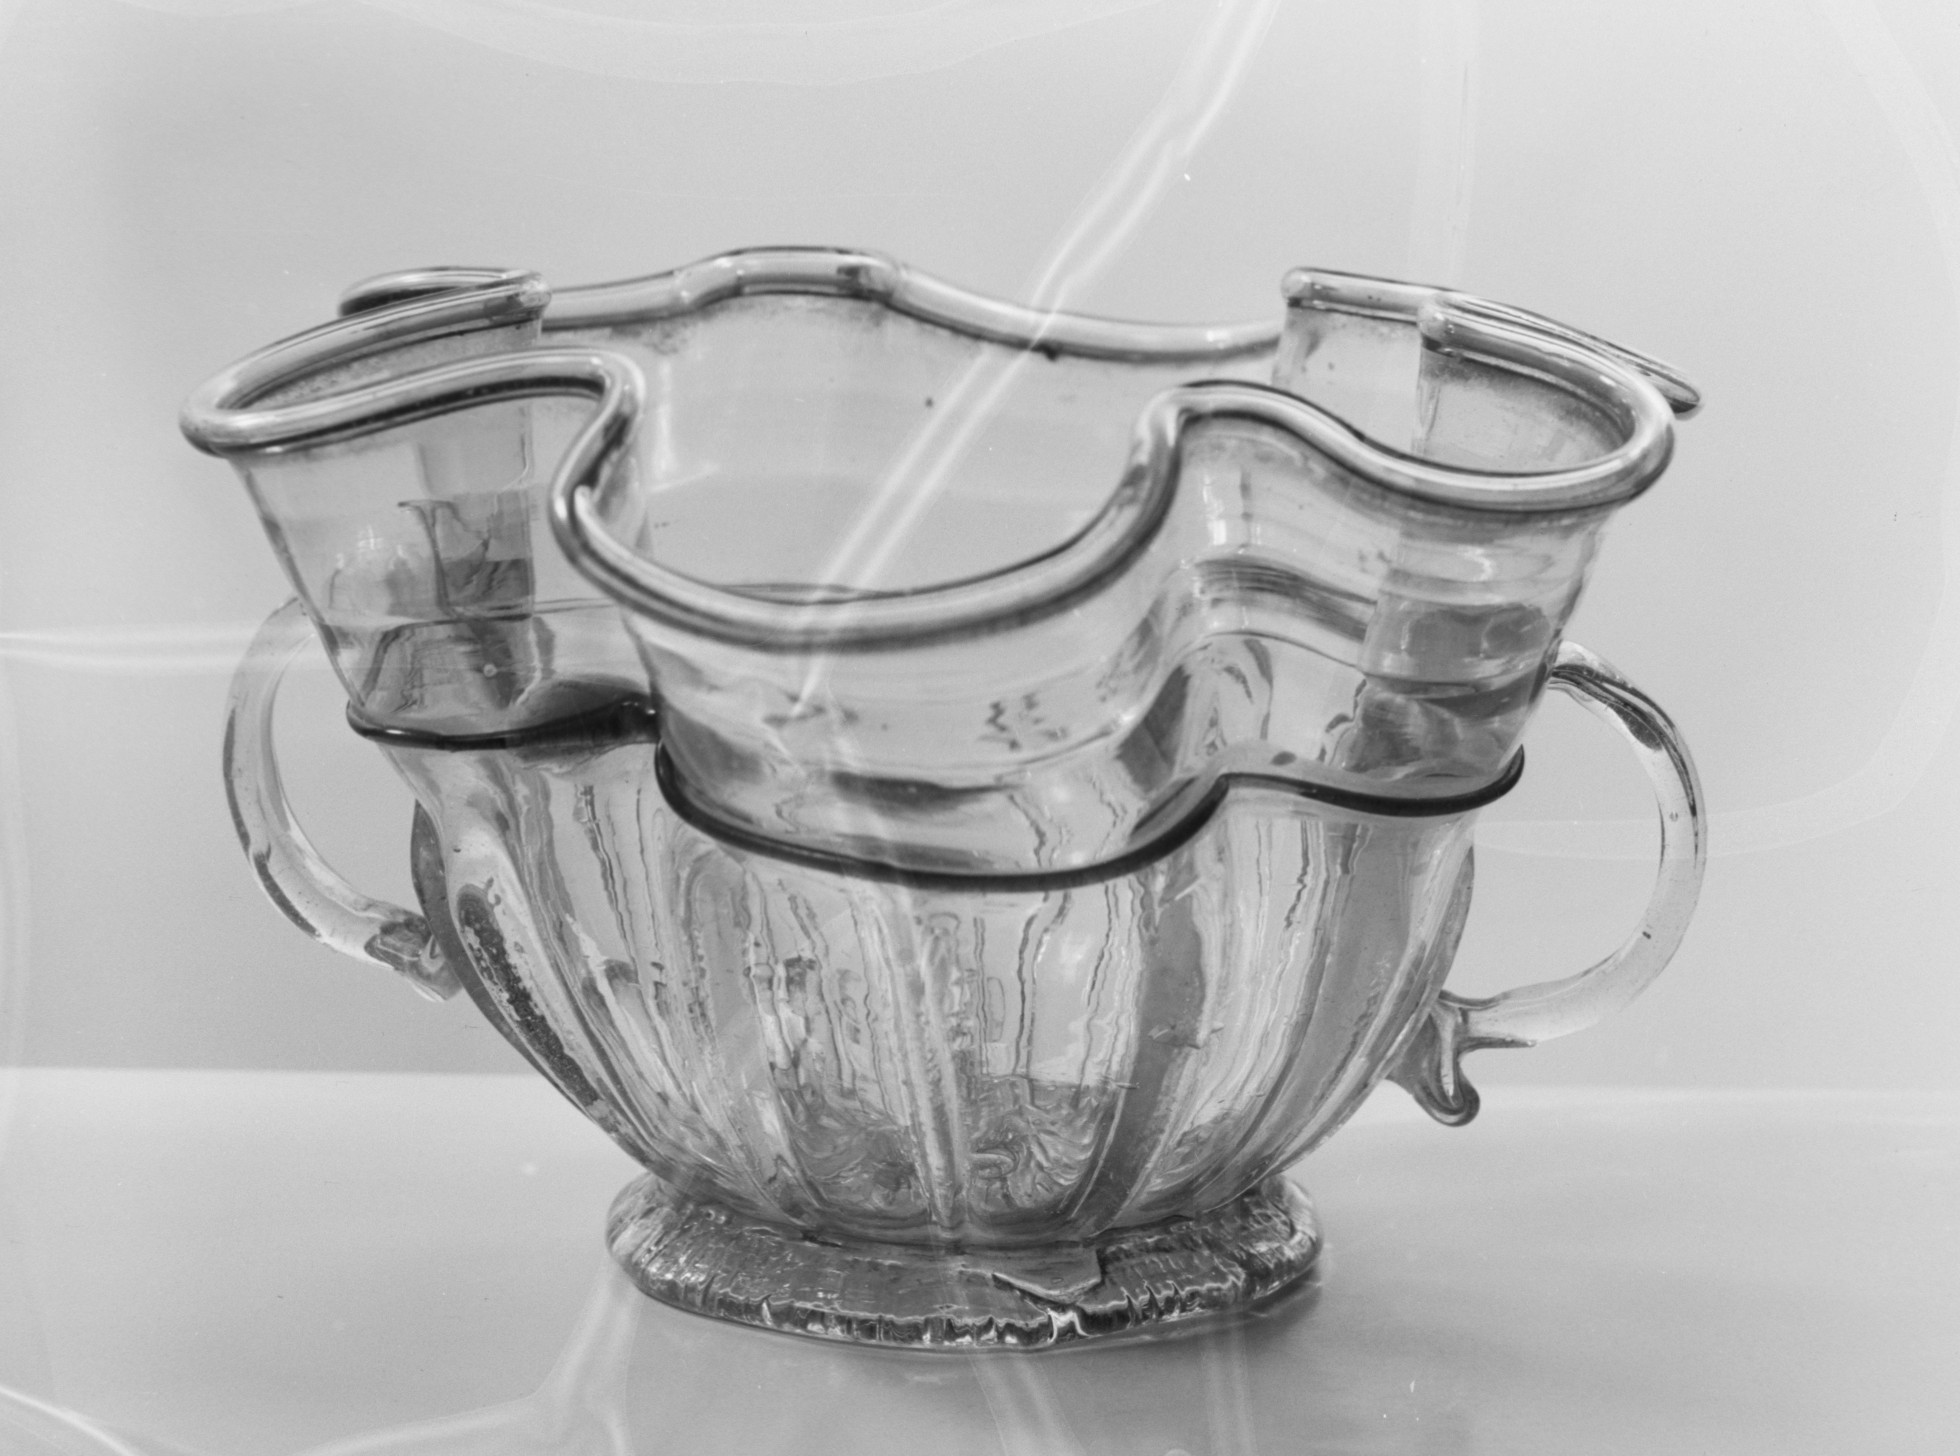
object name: bowl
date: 1701-1800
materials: glass